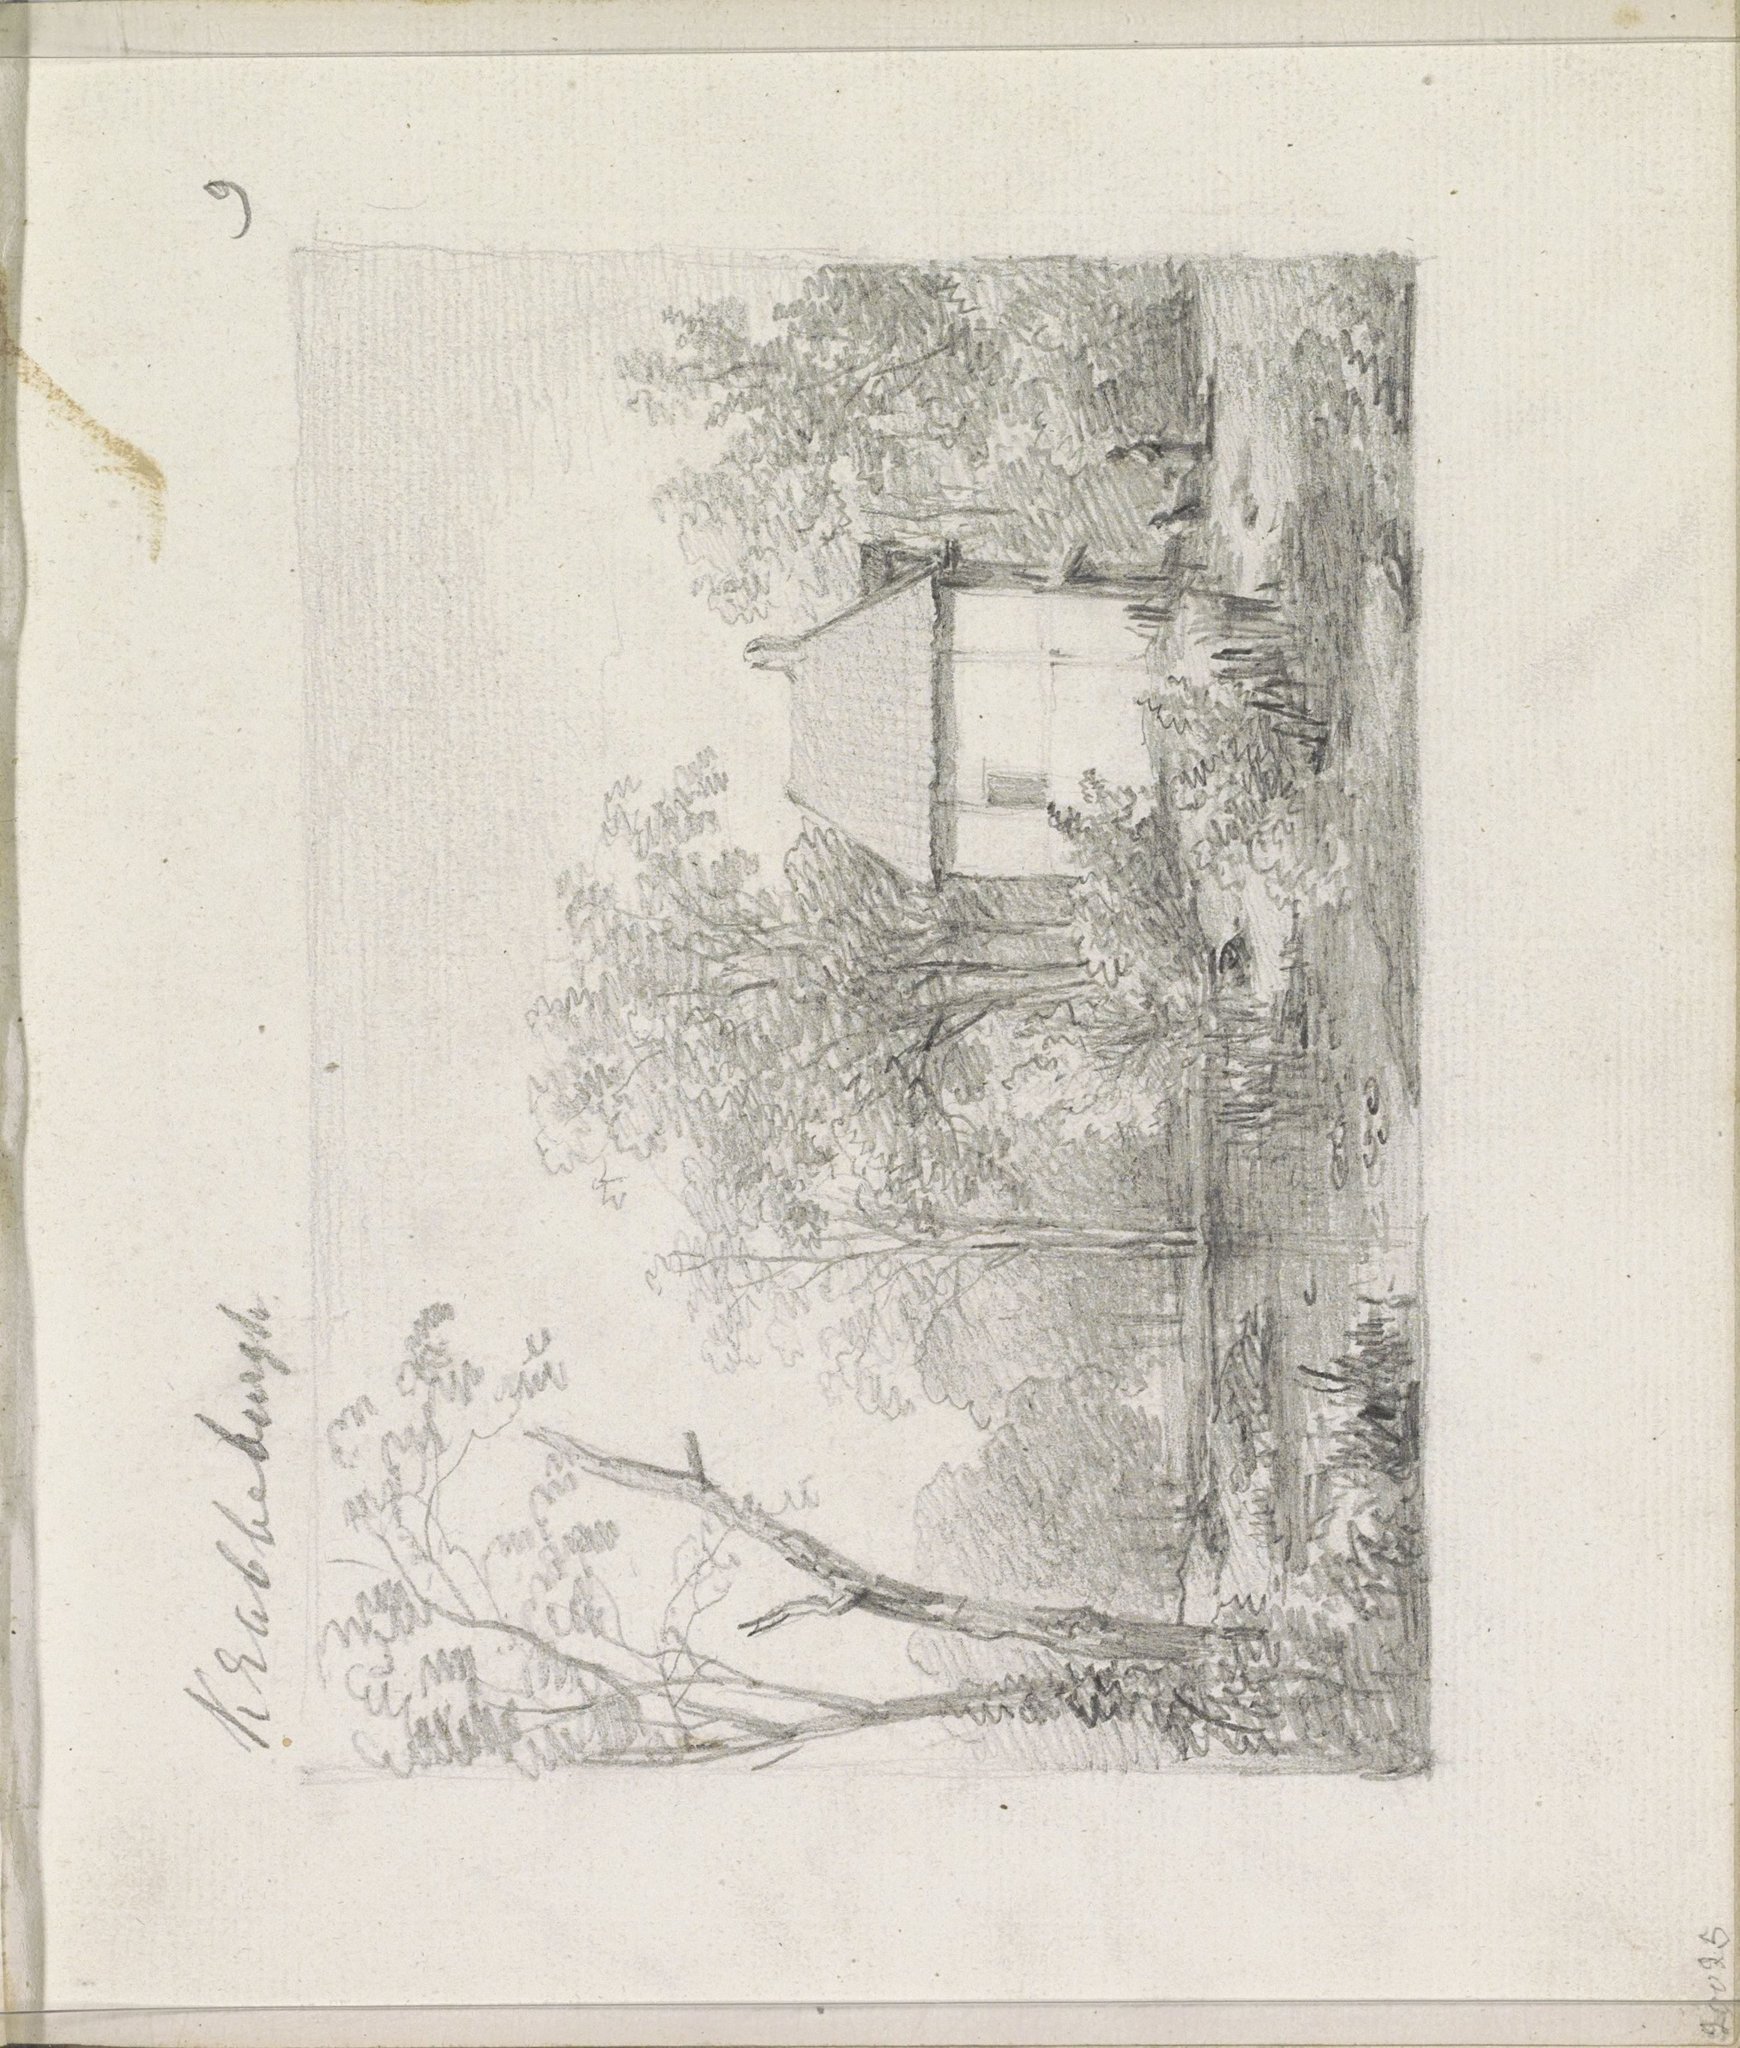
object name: sketchbook leaf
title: Huis aan het water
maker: andreas schelfhout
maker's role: draughtsman, painter, print maker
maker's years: 1787-1870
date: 1825-1829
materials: chalk, paper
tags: landscapes with waters, waterscapes, seascapes (in the temperate zone), farm or solitary house in landscape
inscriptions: annotation: ‘Krabbeburgh’, number: ‘9/ 20025’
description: Blad 23 recto uit een schetsboek met 95 bladen.